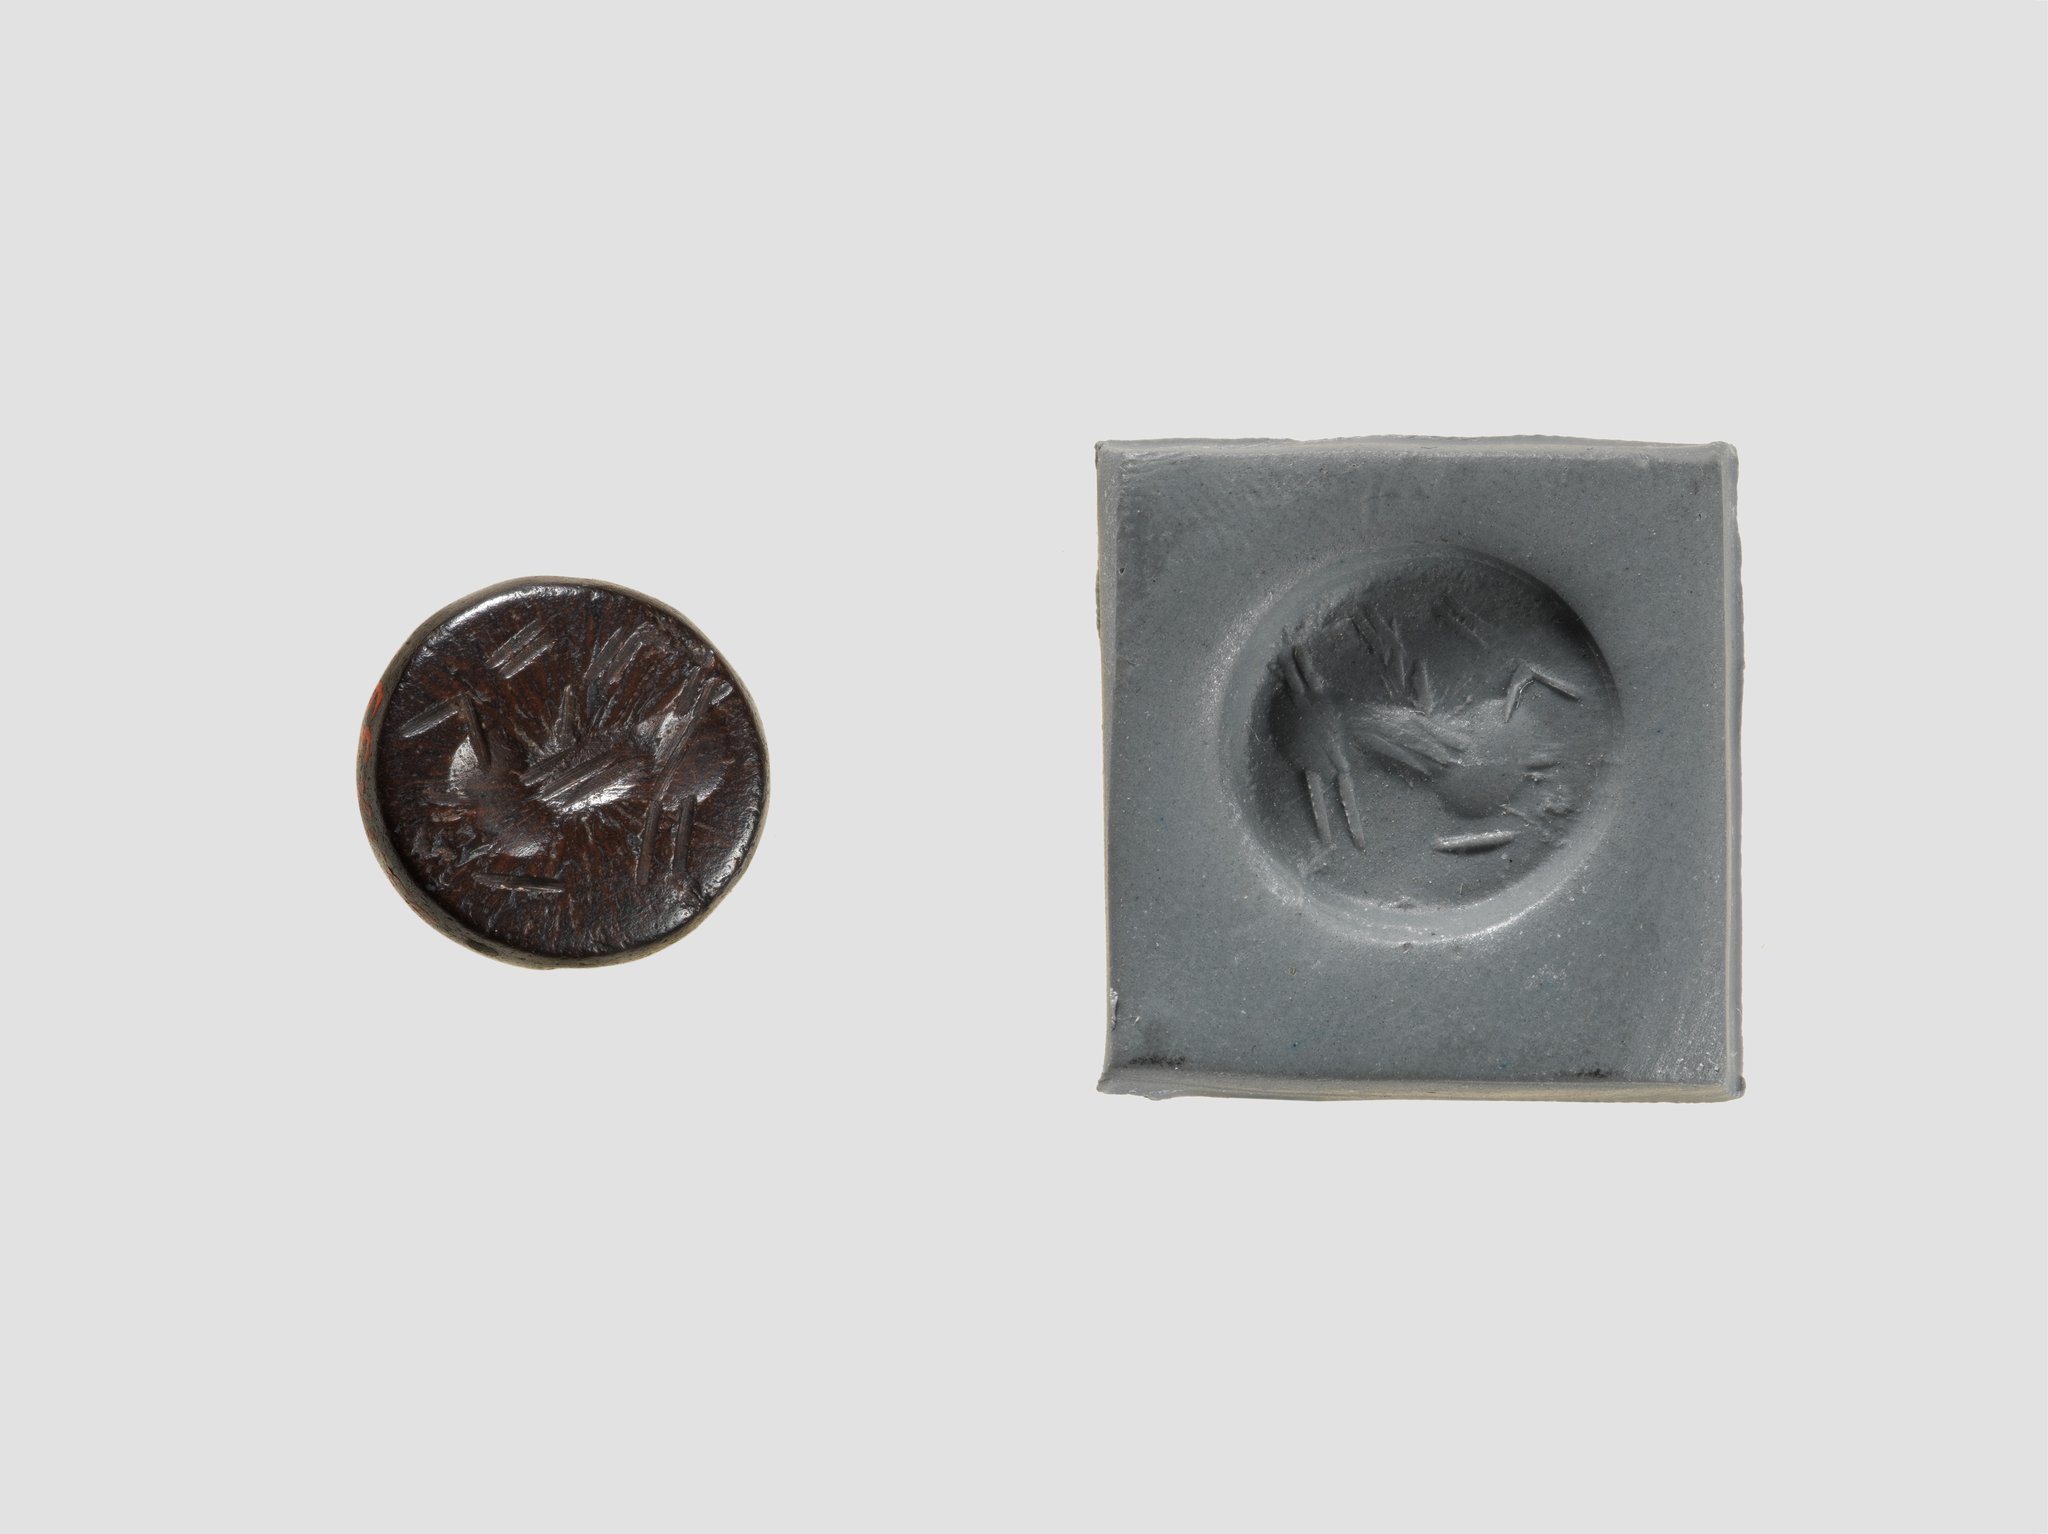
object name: stamp seal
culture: sasanian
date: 201-300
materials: mineral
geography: iran or mesopotamia